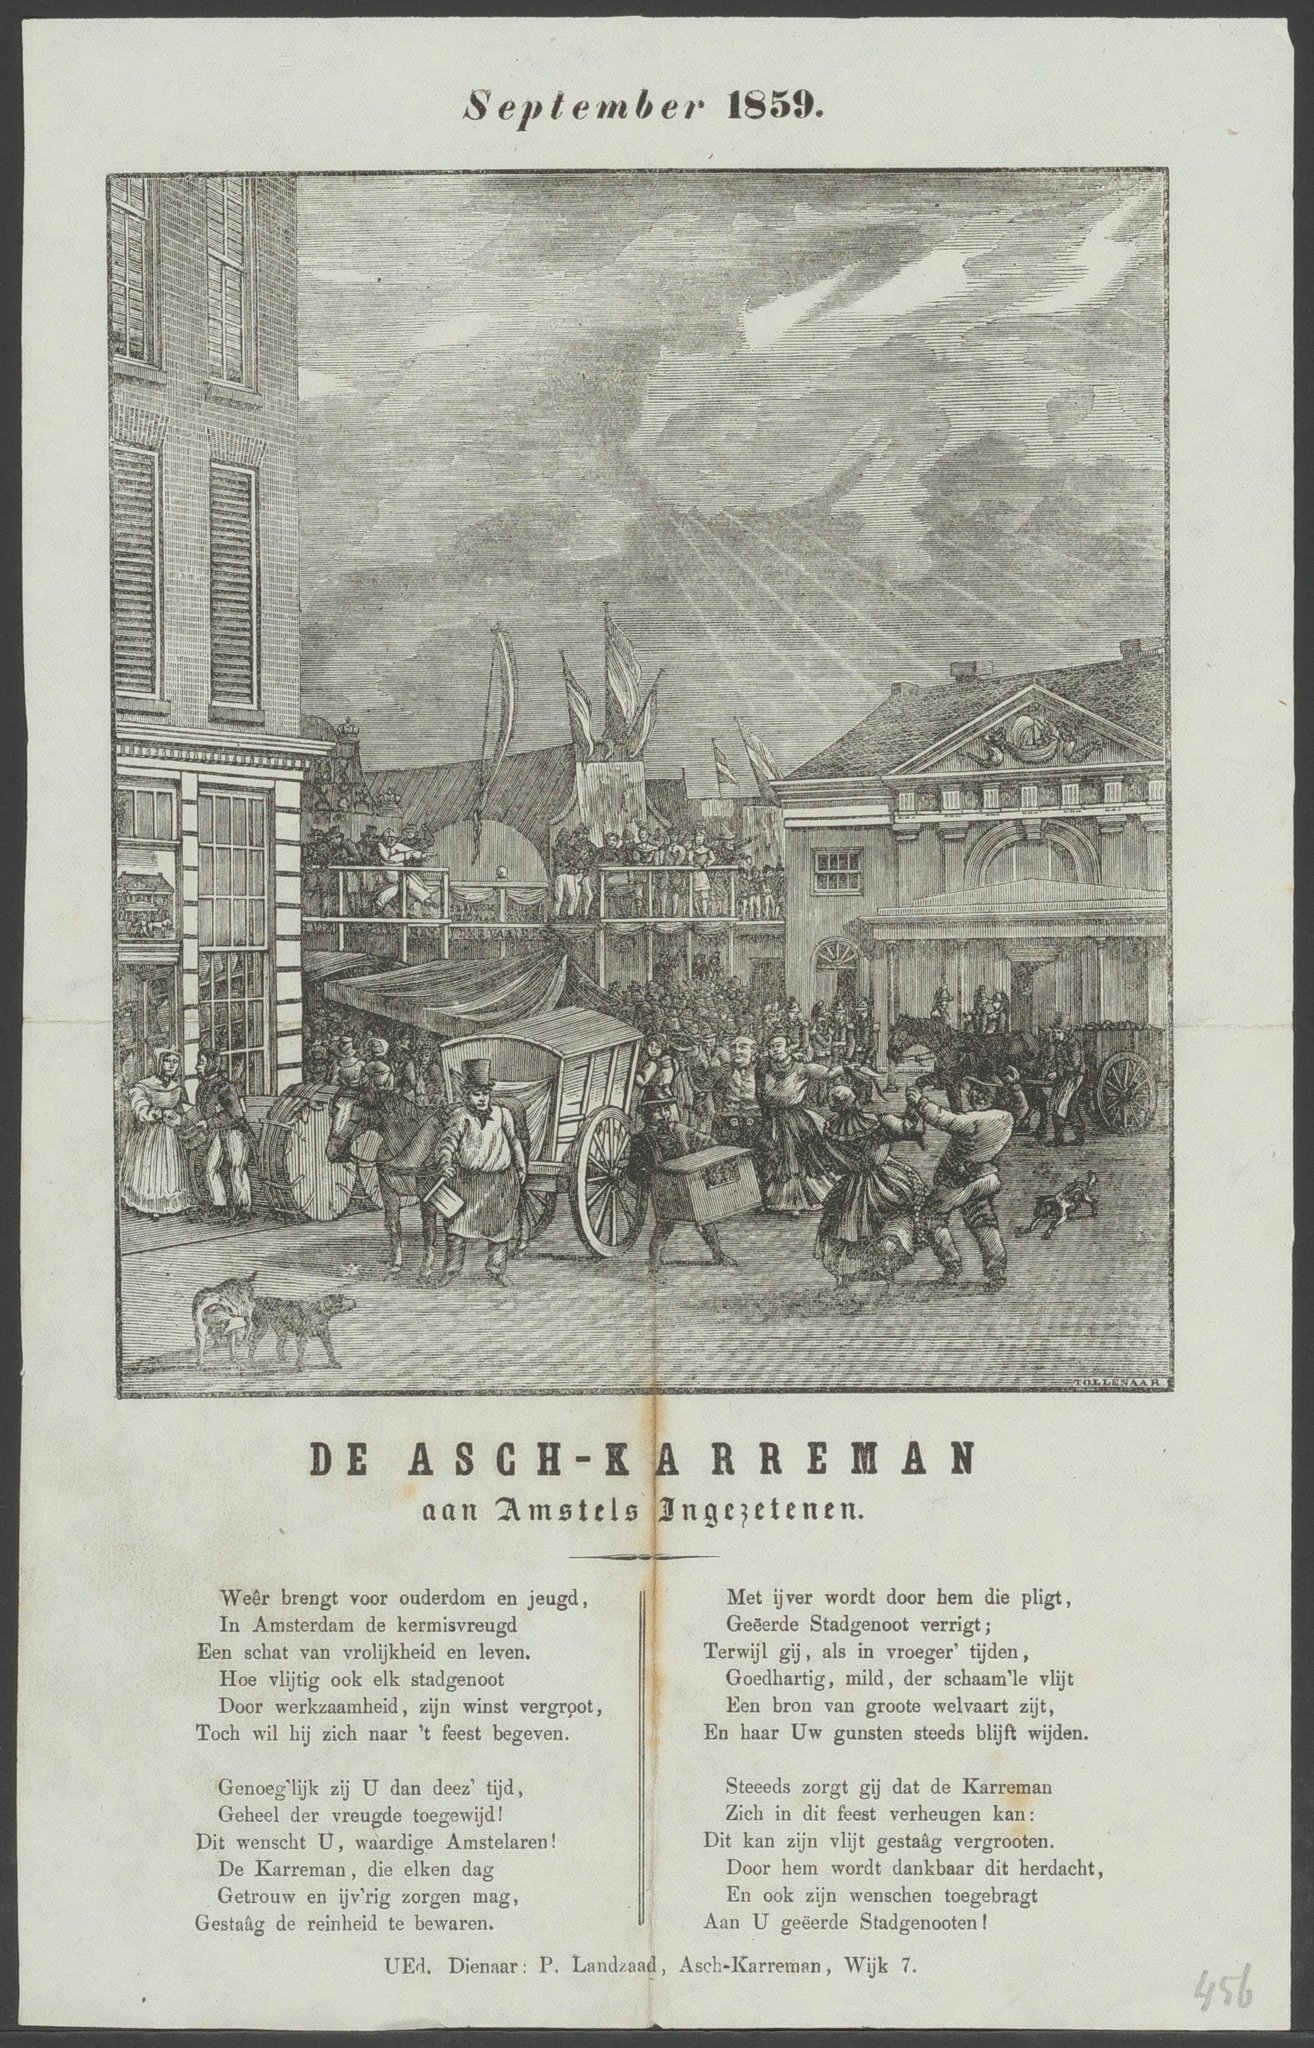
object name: print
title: Asch-Karmans kermis-wensch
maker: dirk wijbrand tollenaar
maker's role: print maker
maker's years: 1808-1858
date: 1859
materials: paper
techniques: letterpress printing, engraving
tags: pleasure fair and circus, garbage collection, amsterdam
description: Kermisprent namens de askarrenmannen (karrenman of vuilnisman) te Amsterdam, september 1859. Gezicht op de kermis op de Botermarkt met de Regulierswaag. Op de markt twee vuilniskarren. Onderaan een gedicht in twee kolommen. Namens P. Landzaad, de askarreman van wijk no. 7. Onderwerpsrubrieken binnen de Atlas Zeden en Gewoonten: Zeden en gewoonten in engeren zin, Volksleven, Volksbladen, Nieuwjaars- en Kerstwenschen, Amsterdam.